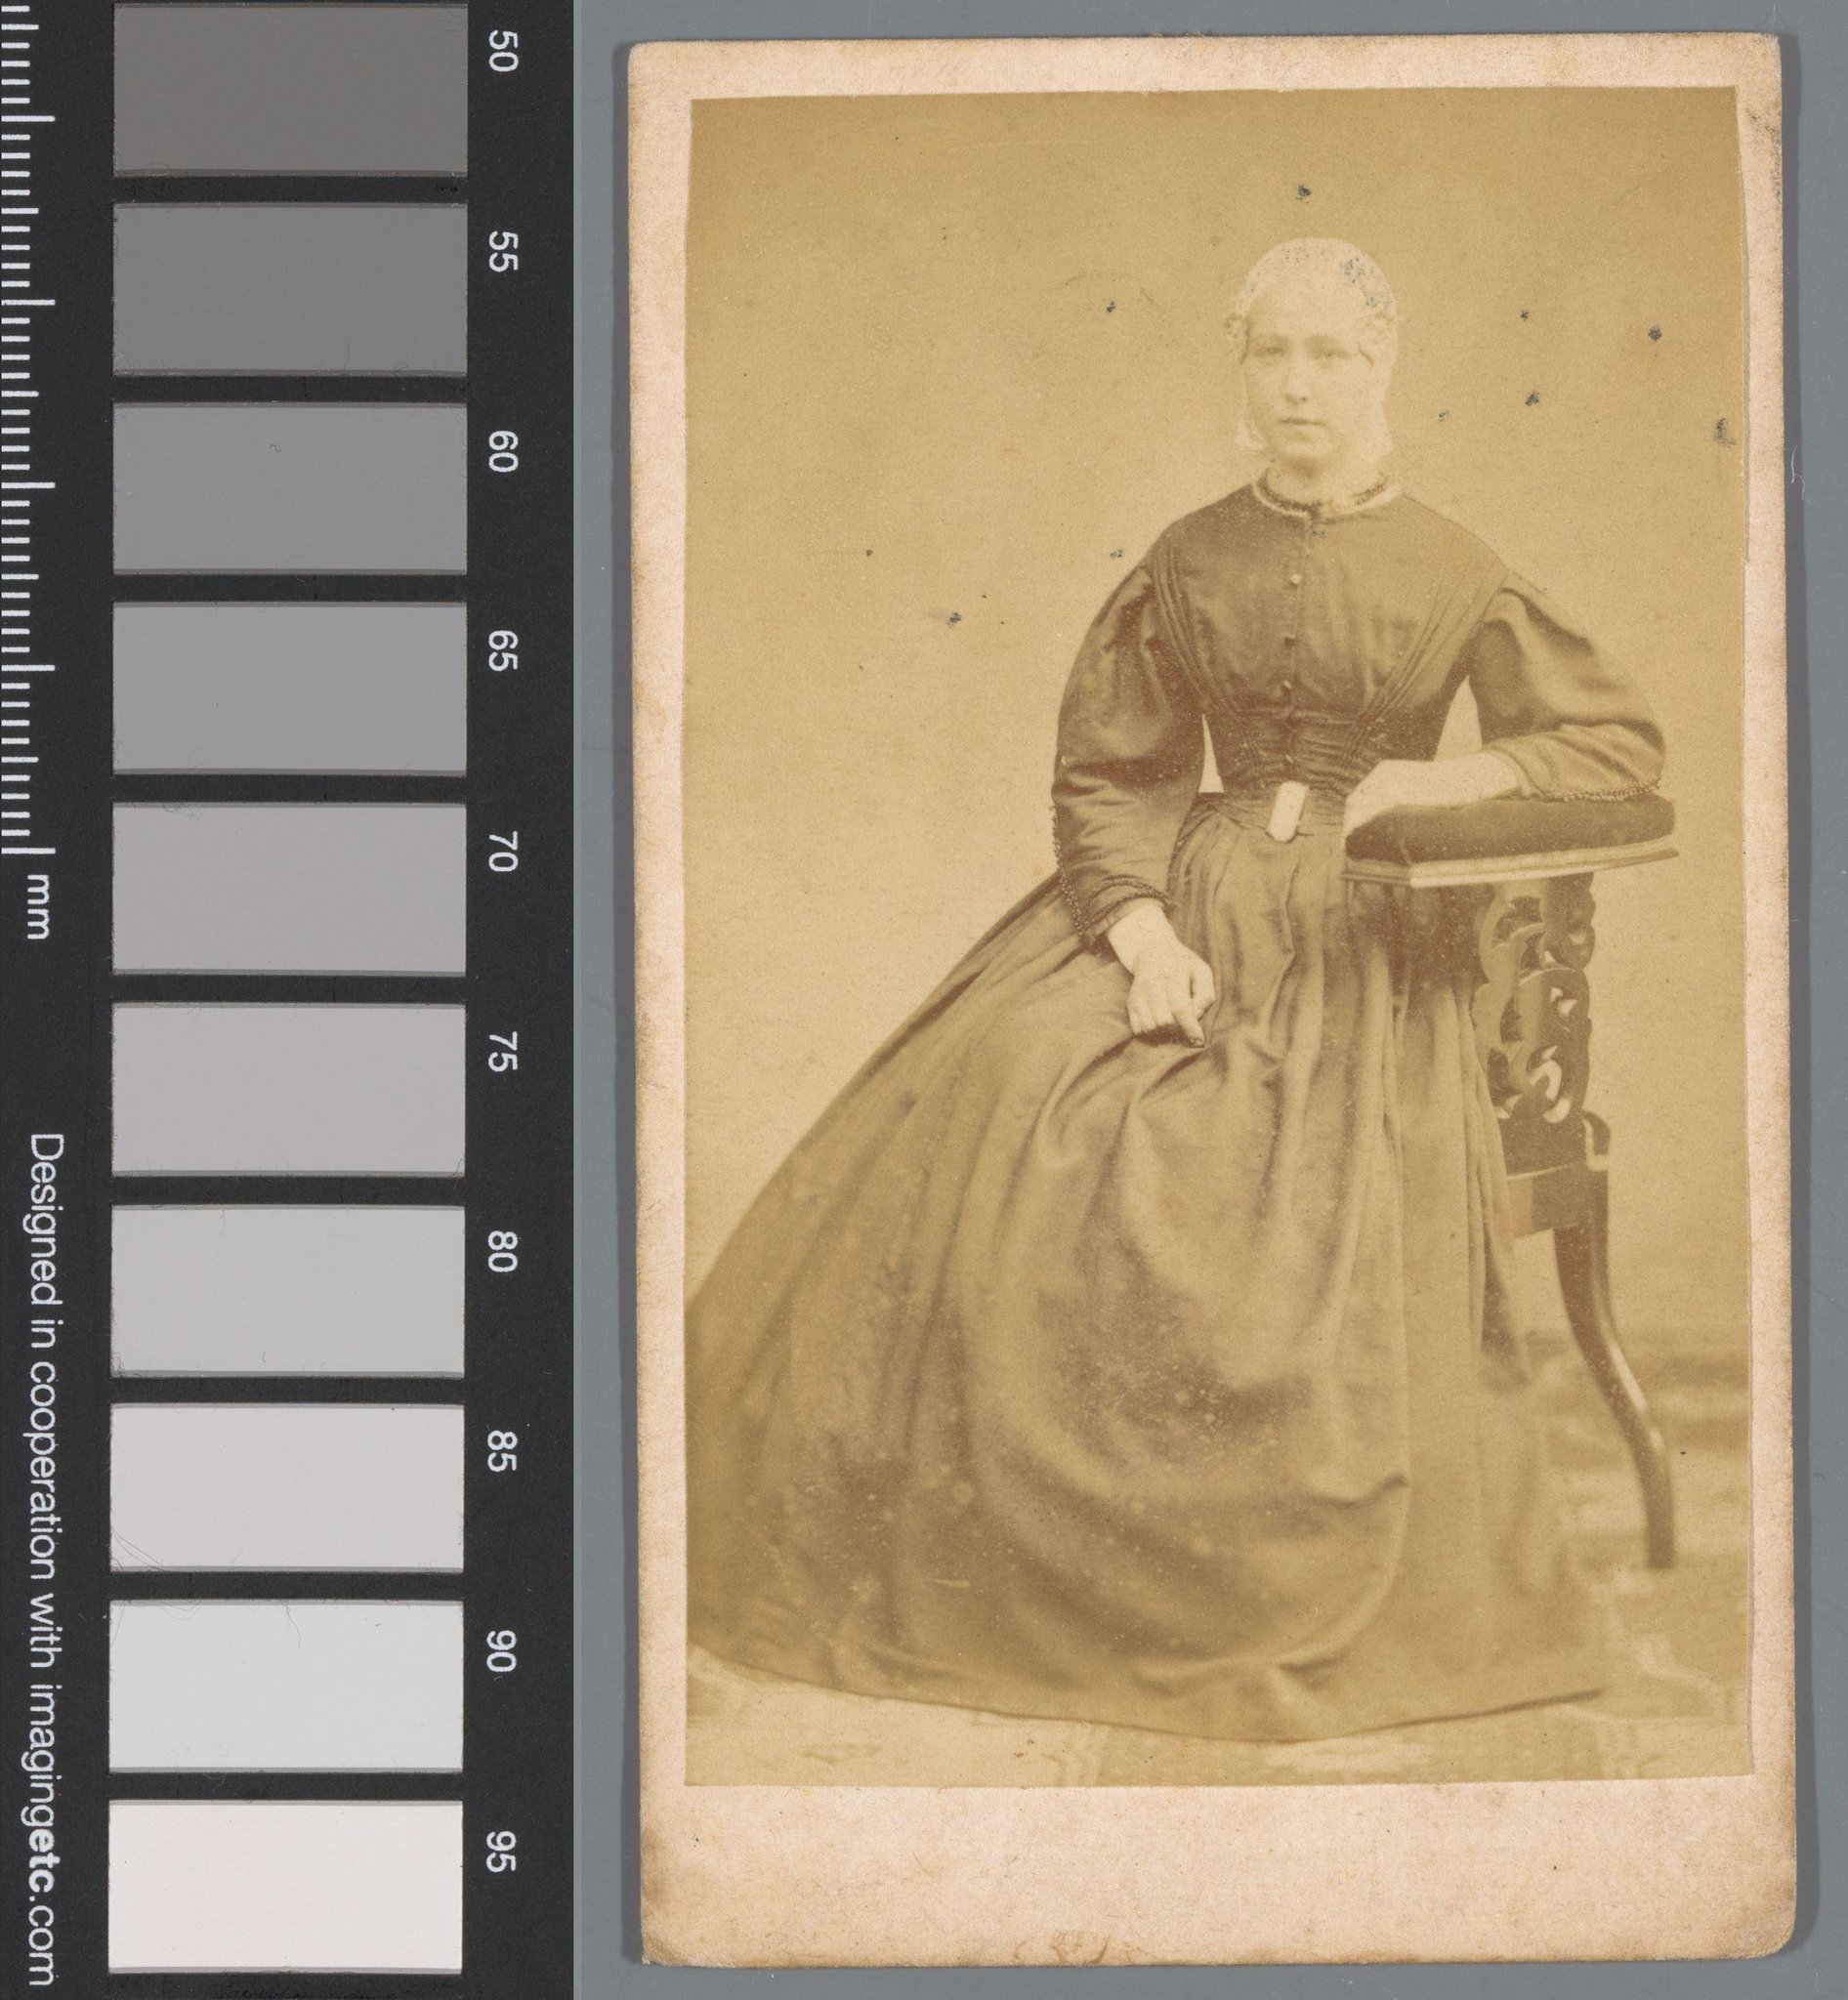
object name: photograph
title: Portret van een onbekende vrouw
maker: leonard ten hagen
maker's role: fotograaf, graveur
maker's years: 1838-1876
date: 1869-1876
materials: cardboard, paper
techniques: albumen print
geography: amsterdam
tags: adult woman, anonymous historical person portrayed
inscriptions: address: ‘Rozengr: by/ de Prinsengr:/ E. E. 6/ AMSTERDAM’